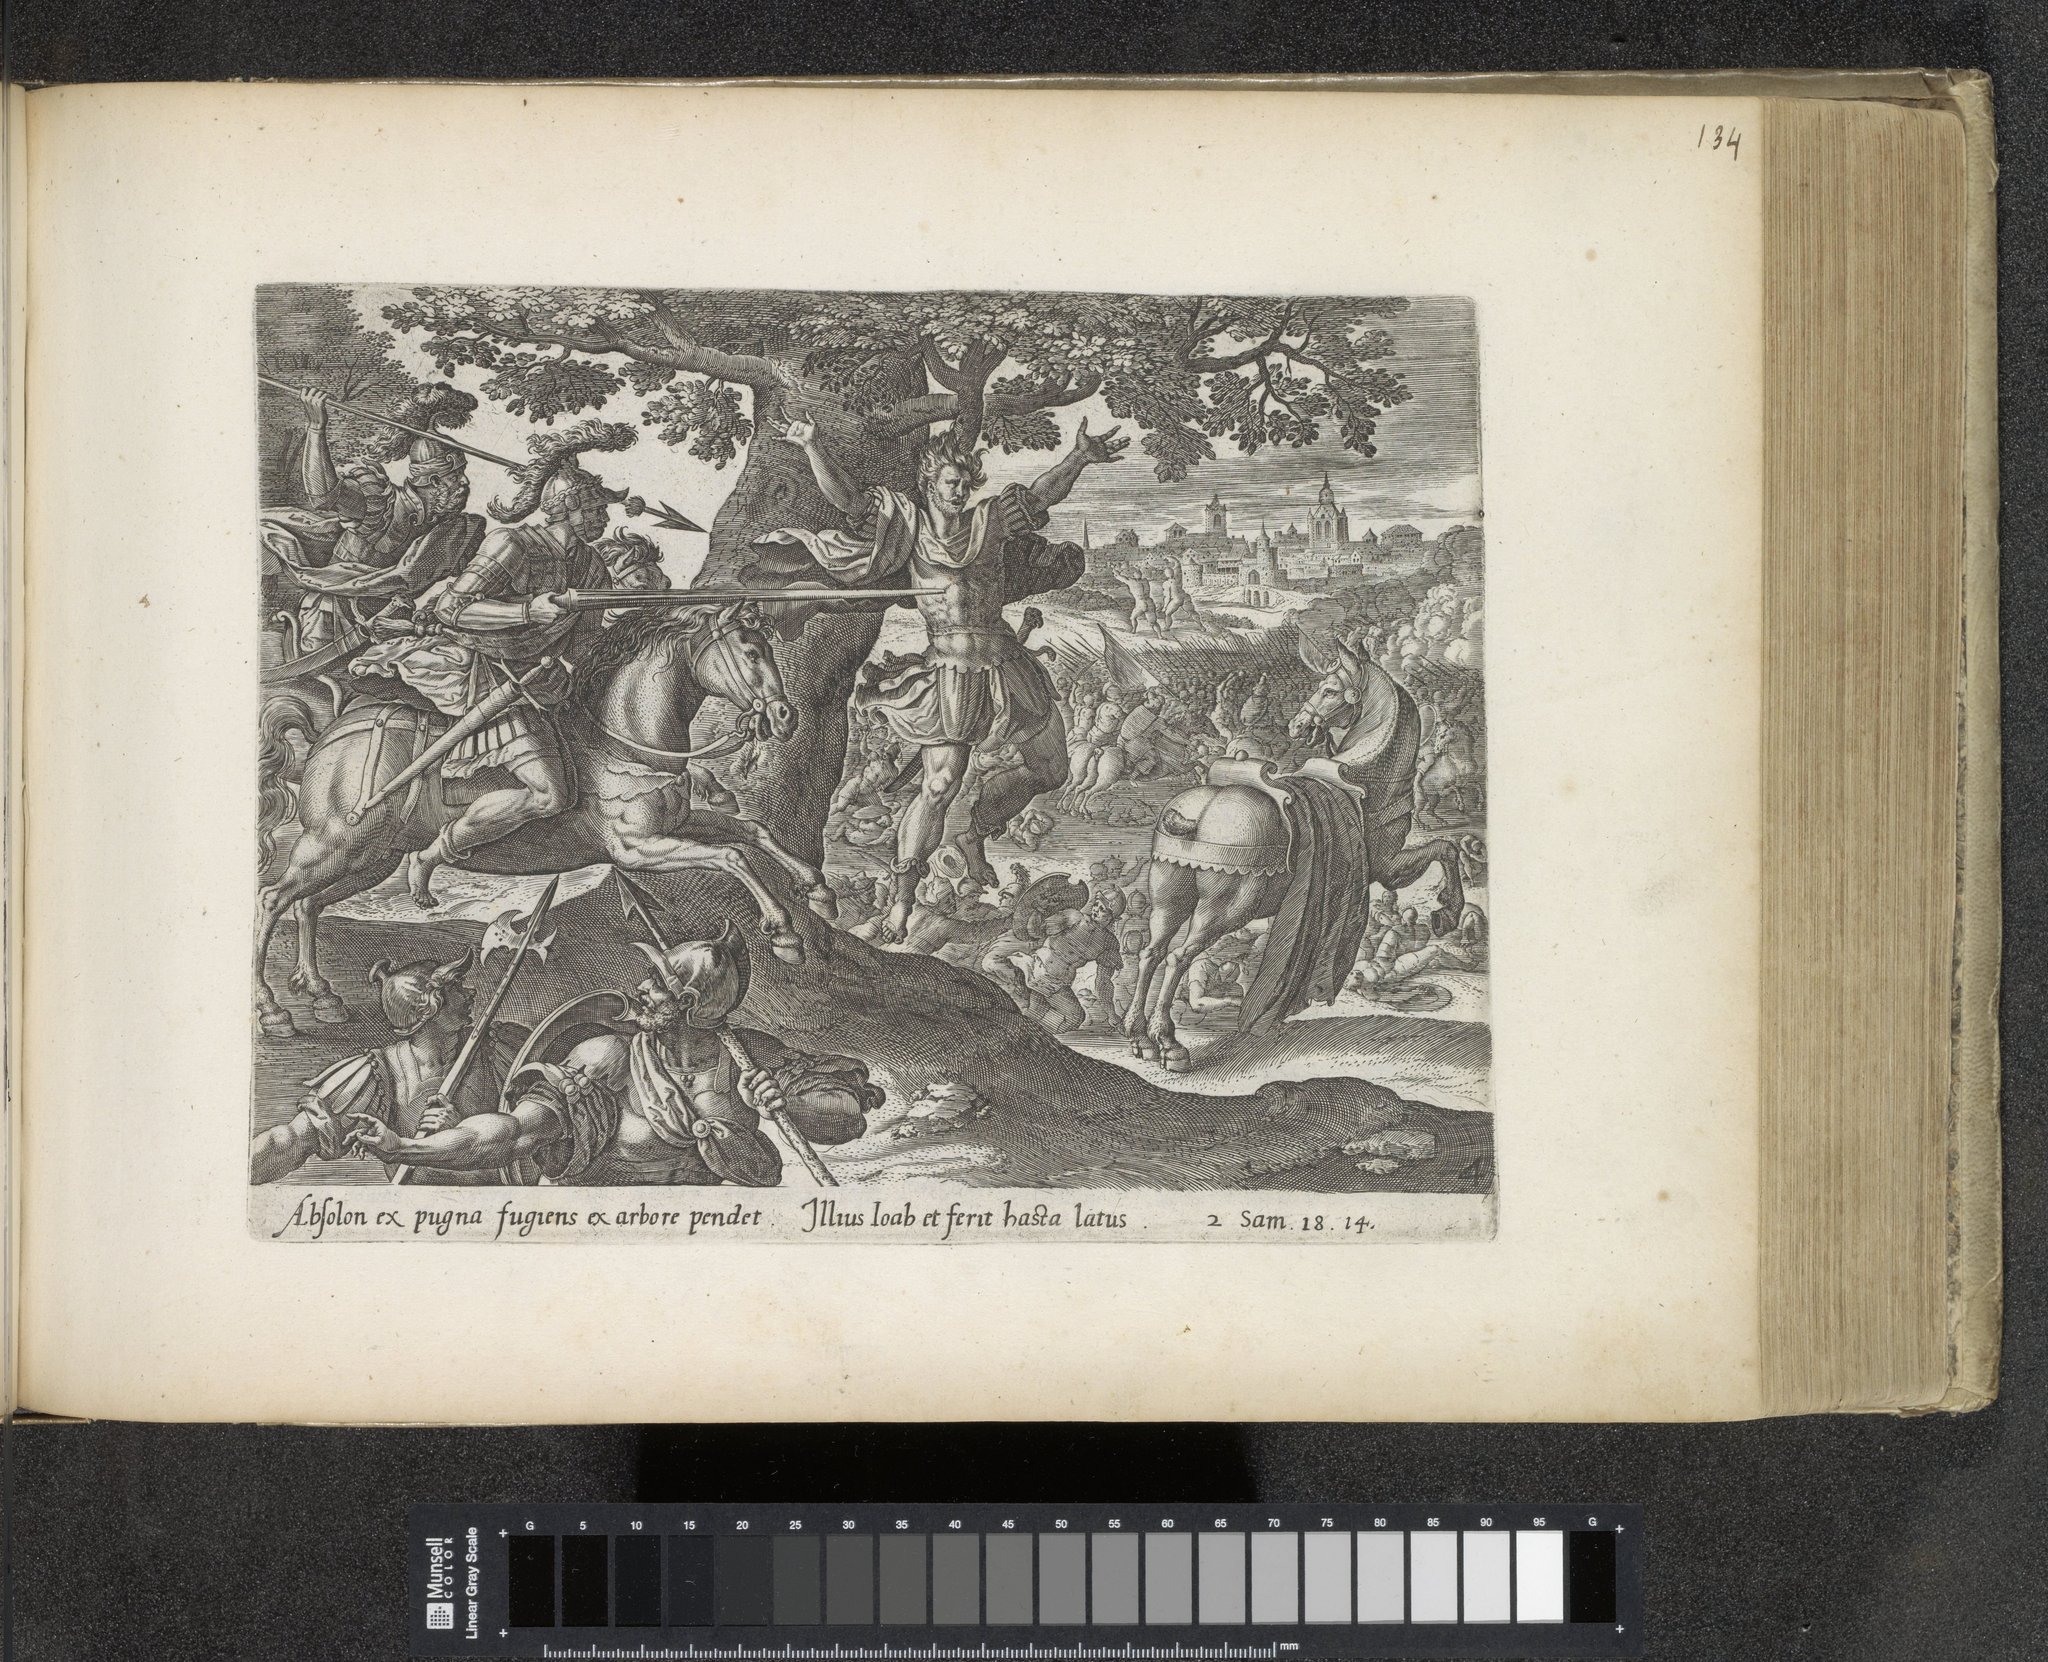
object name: album leaf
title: Dood van Absalom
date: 1585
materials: paper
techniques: engraving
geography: amsterdam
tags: absalom, put to flight on a mule, remains hanging by his hair in an oak-tree, joab stabs absalom with three spears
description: Joab stoot met zijn lans in de borst van Absalom, die nog levend in de boom hangt waar hij met zijn haren in verstrikt is geraakt. Onder de voorstelling een verwijzing in het Latijn naar de Bijbeltekst in 2 Sam. 18:14. Deze prent maakt deel uit van een album.